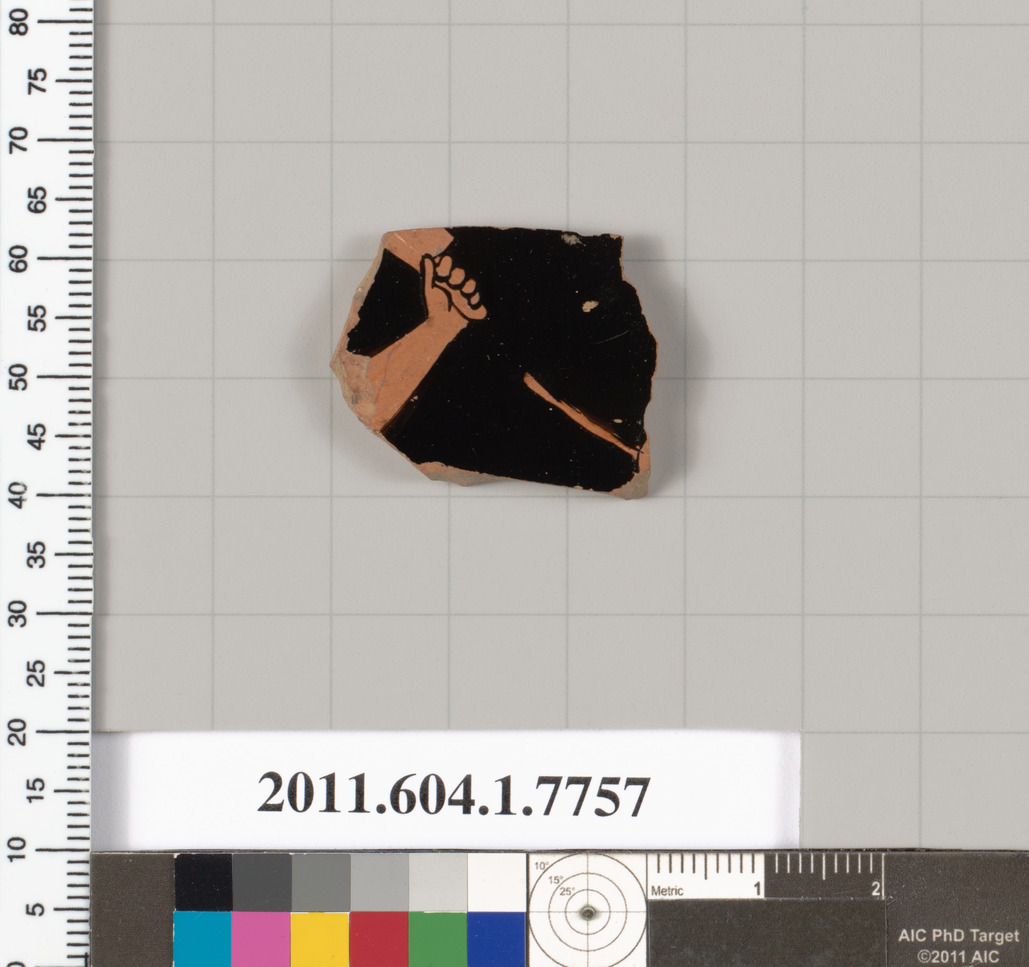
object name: kylix fragment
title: Terracotta fragment of a kylix (drinking cup)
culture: greek, attic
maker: boot painter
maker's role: artist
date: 480-470 BCE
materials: terracotta